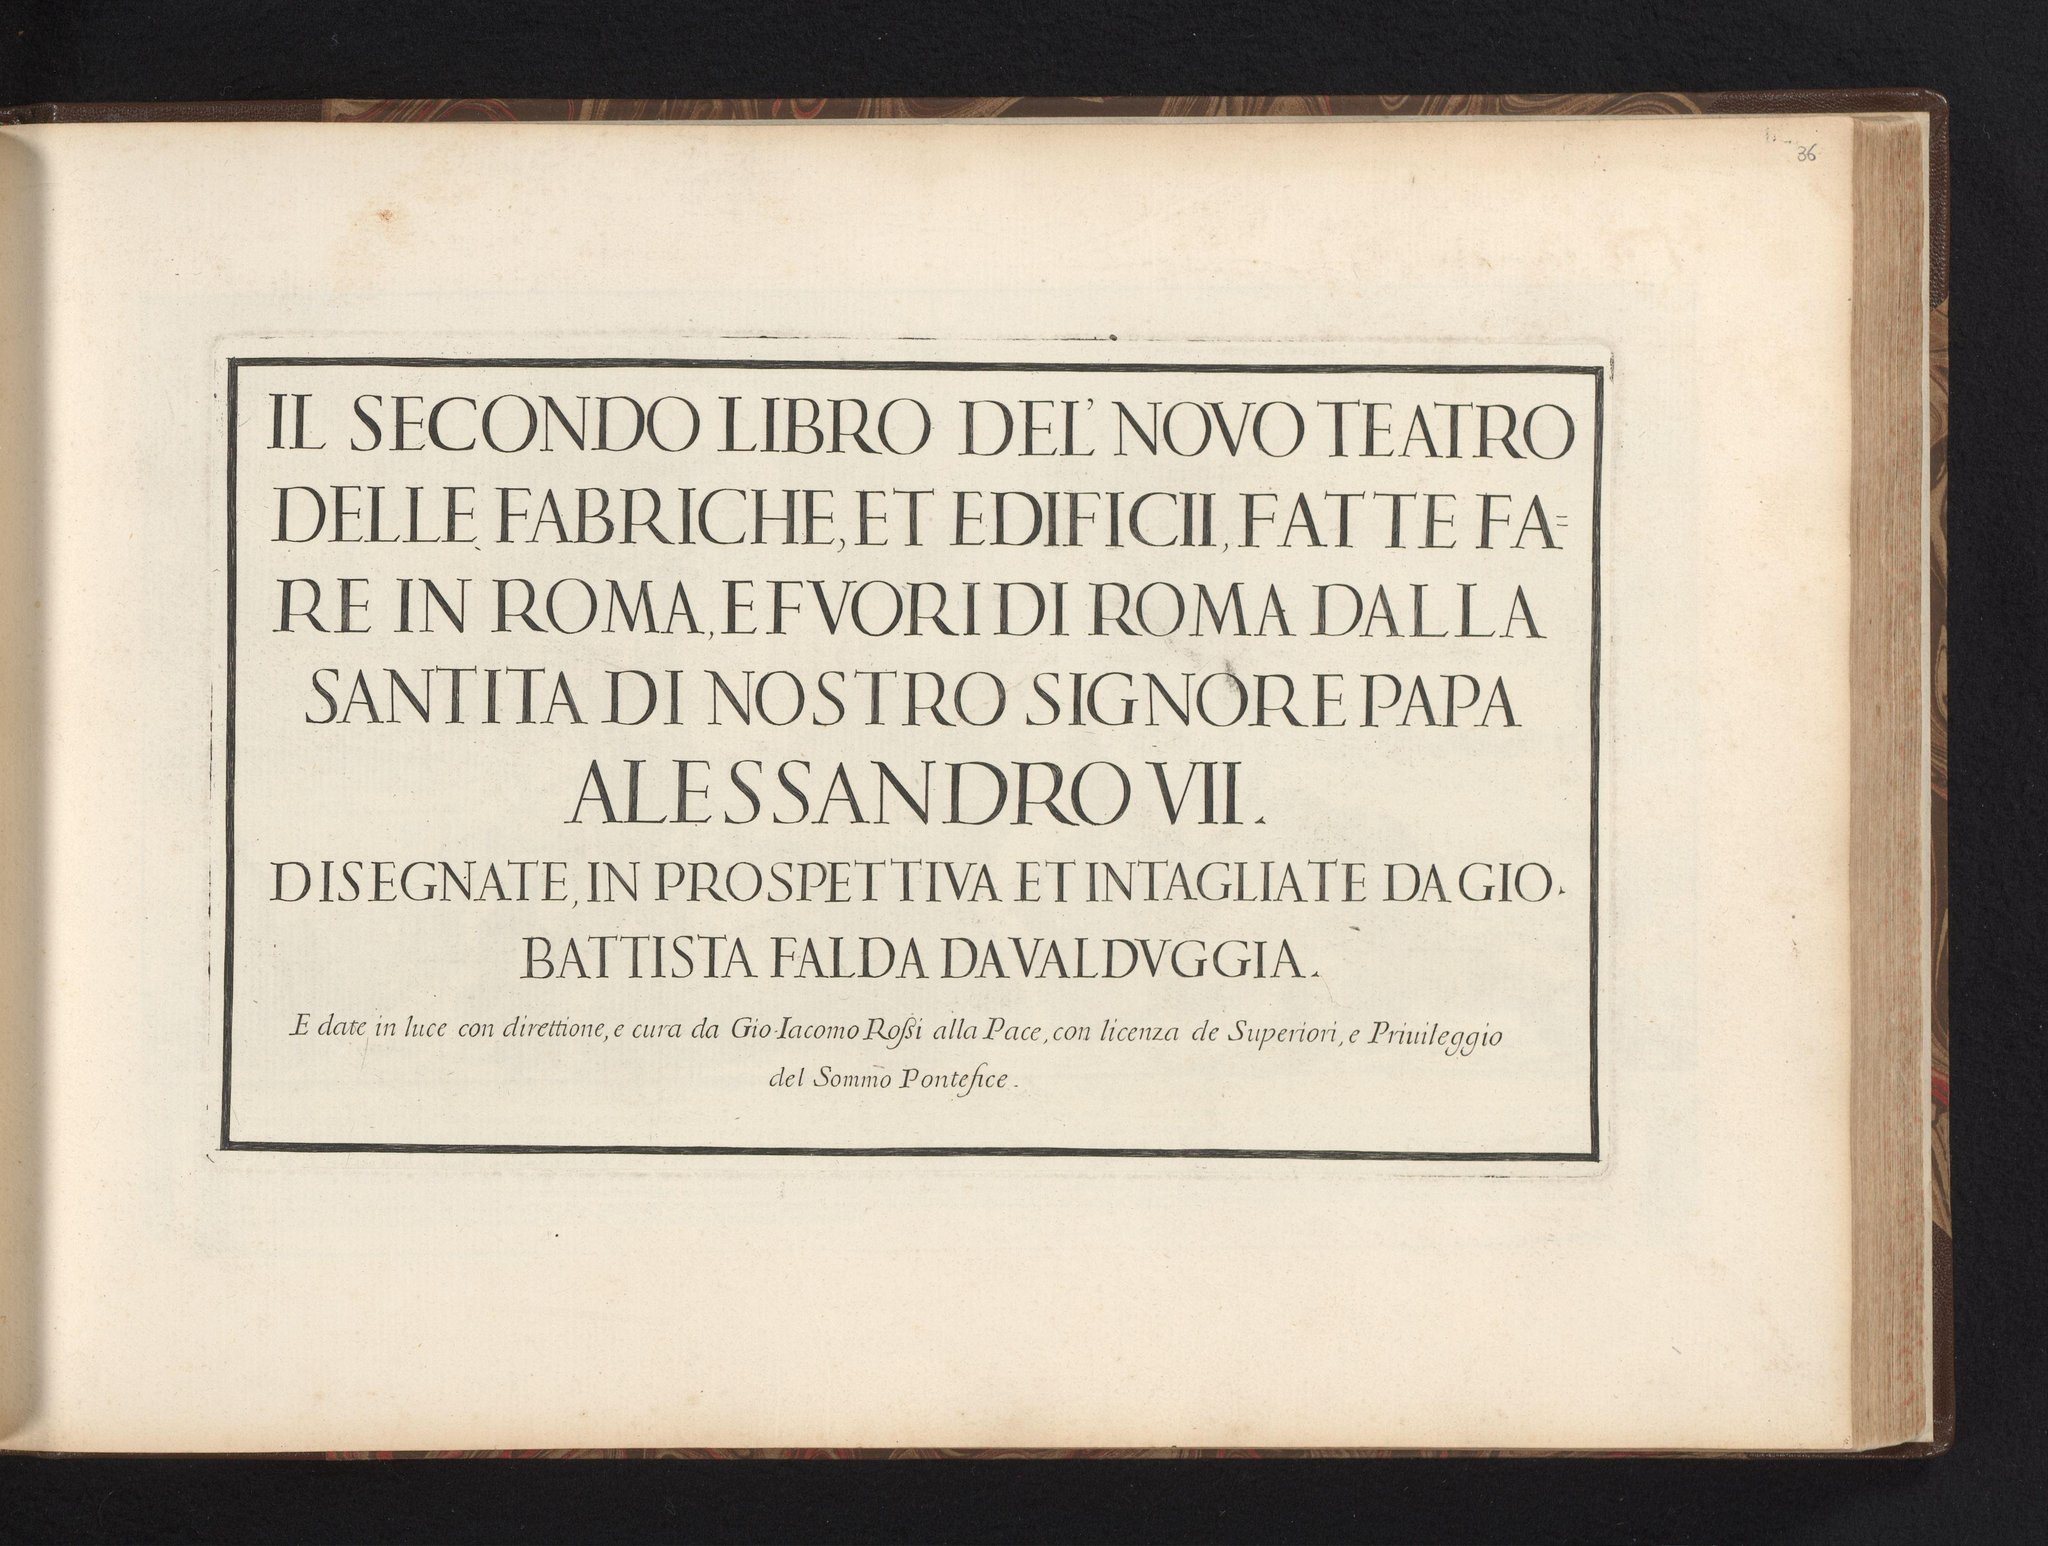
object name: album leaf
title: Il nuovo teatro di Roma moderna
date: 1665-1667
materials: paper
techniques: etching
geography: italy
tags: rome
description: Deze titelprent maakt deel uit van een reeks van 17 prenten met voorstellingen van gebouwen in Rome. Samen met vier andere reeksen vormt het de grote reeks: 'Il nuovo teatro di Roma moderna'.